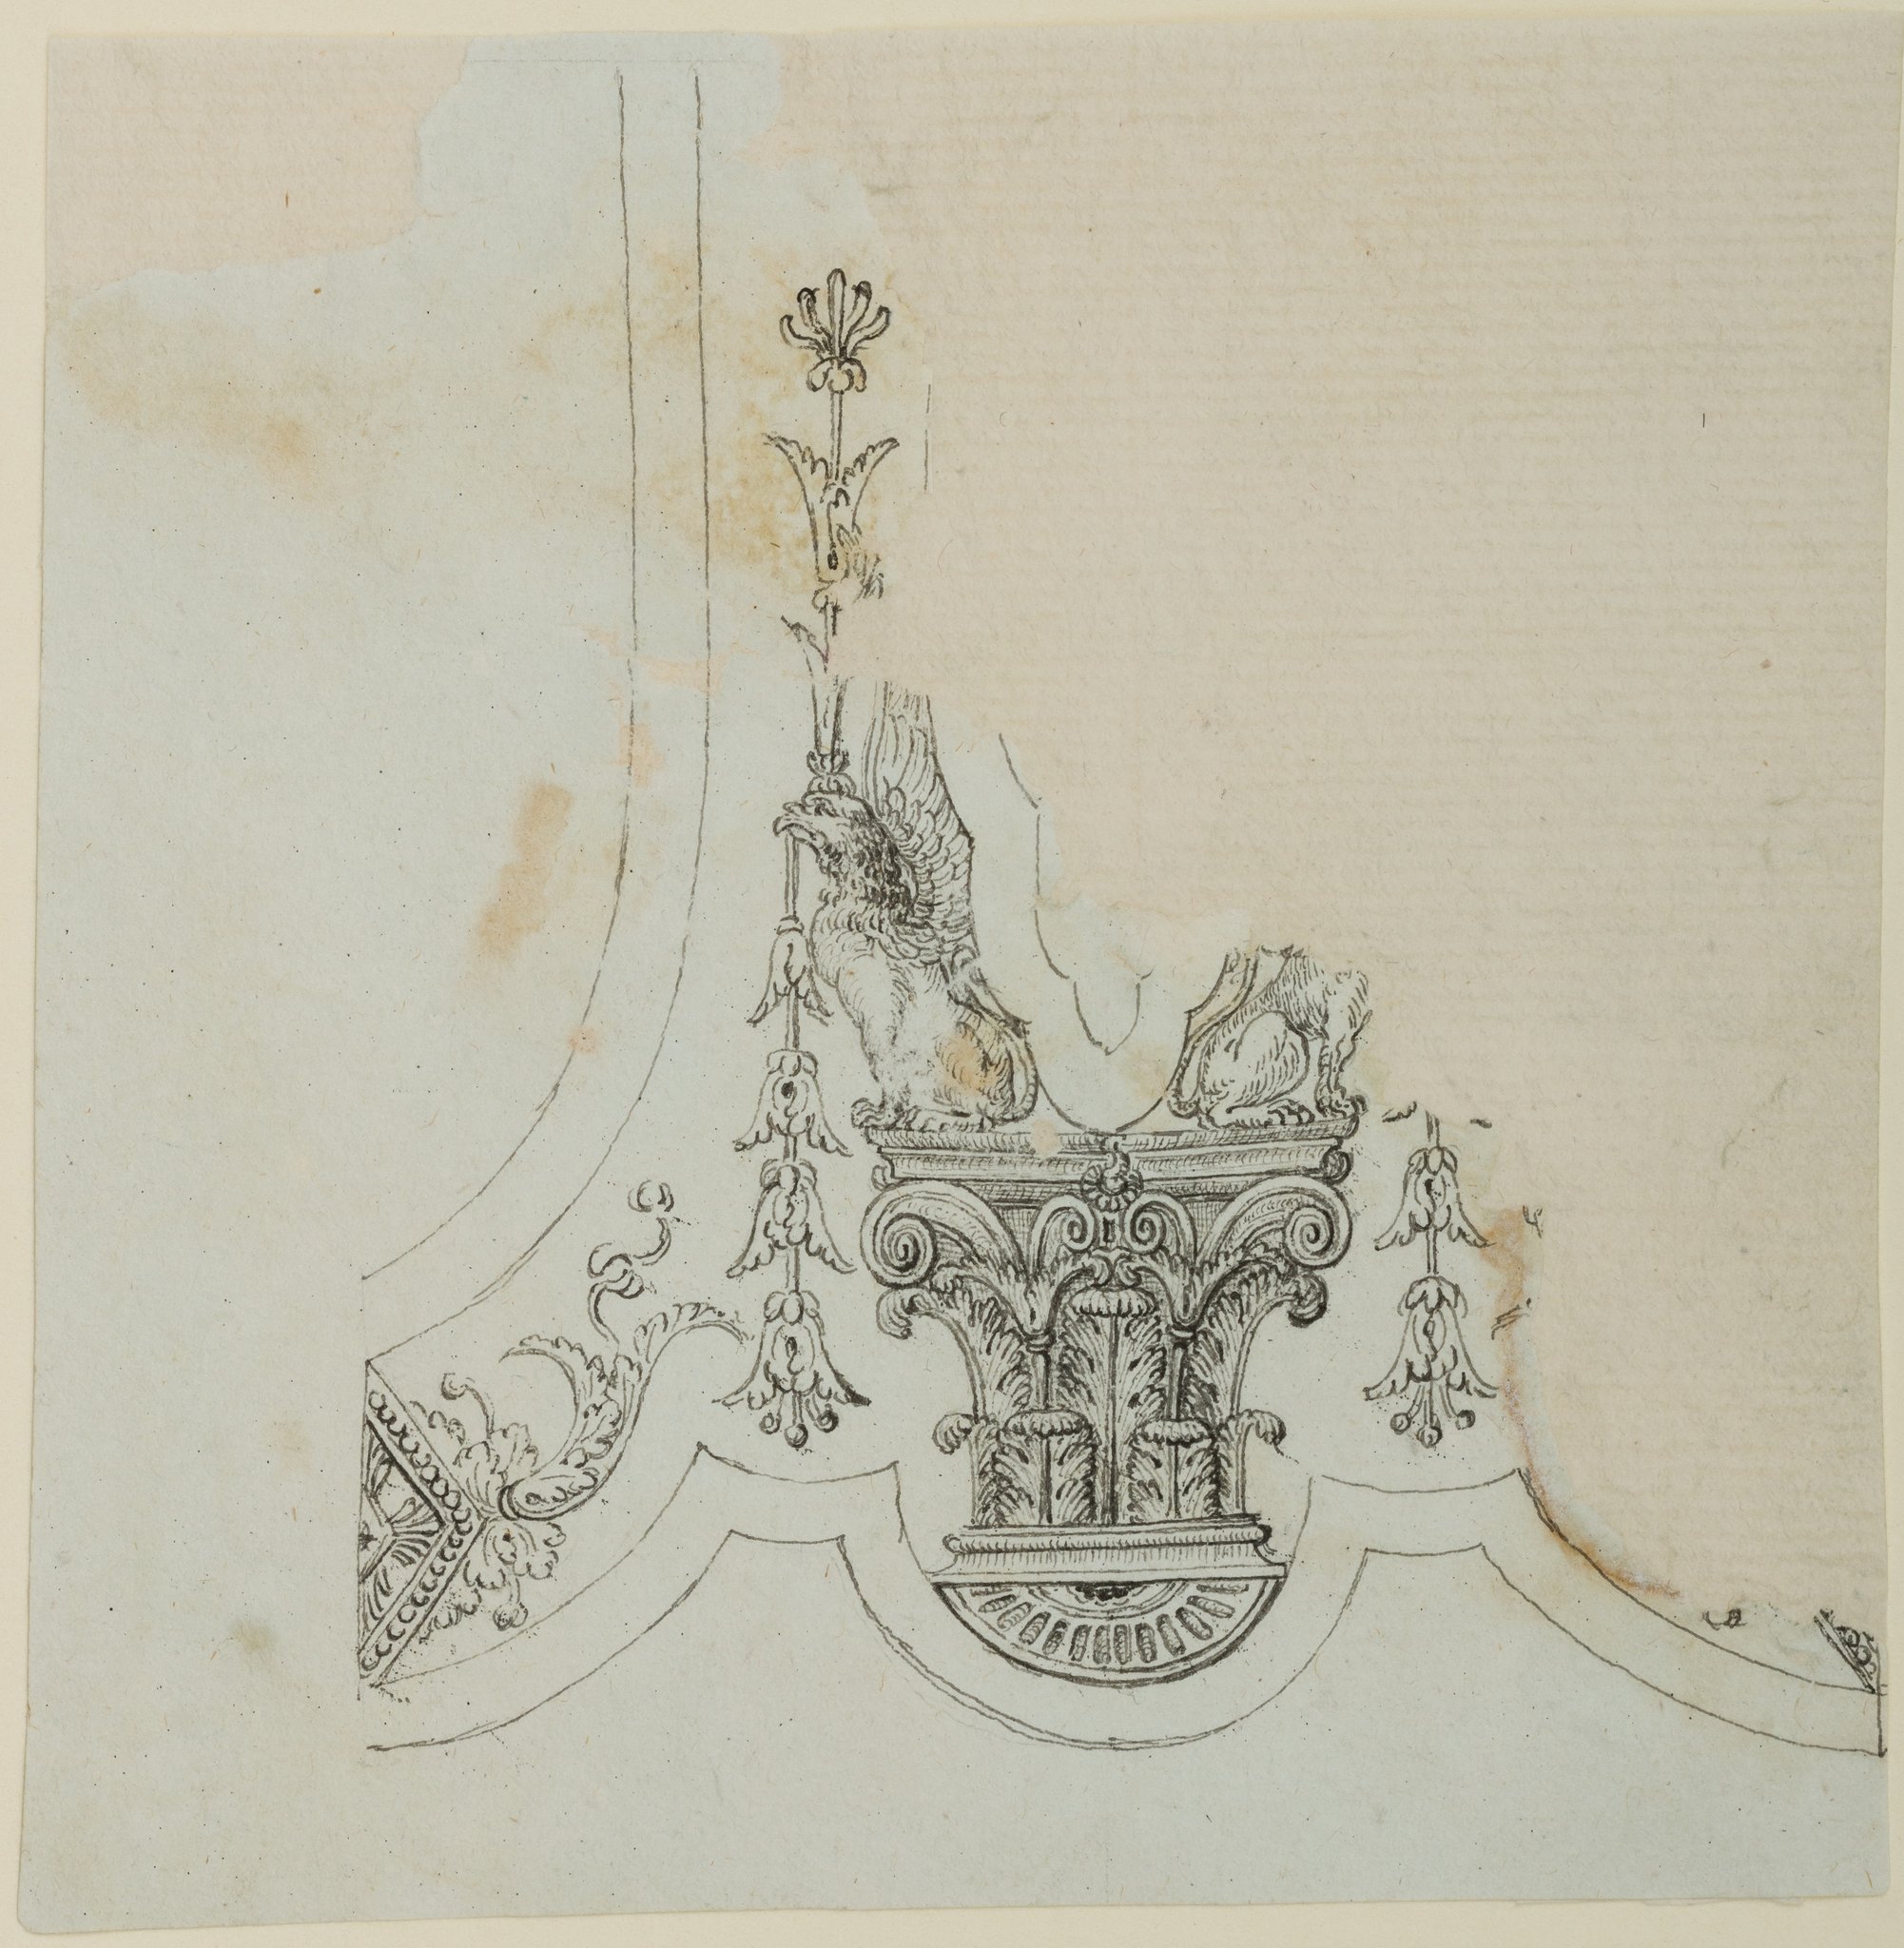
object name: drawing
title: Partial Design for the Decoration of the Surround of the Barrel Tang of a Firearm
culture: french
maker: nicolas noël boutet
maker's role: designer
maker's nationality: french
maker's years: 1761-1833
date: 1797-1805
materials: ink, paper, pencil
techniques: wash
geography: france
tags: ornament,griffins